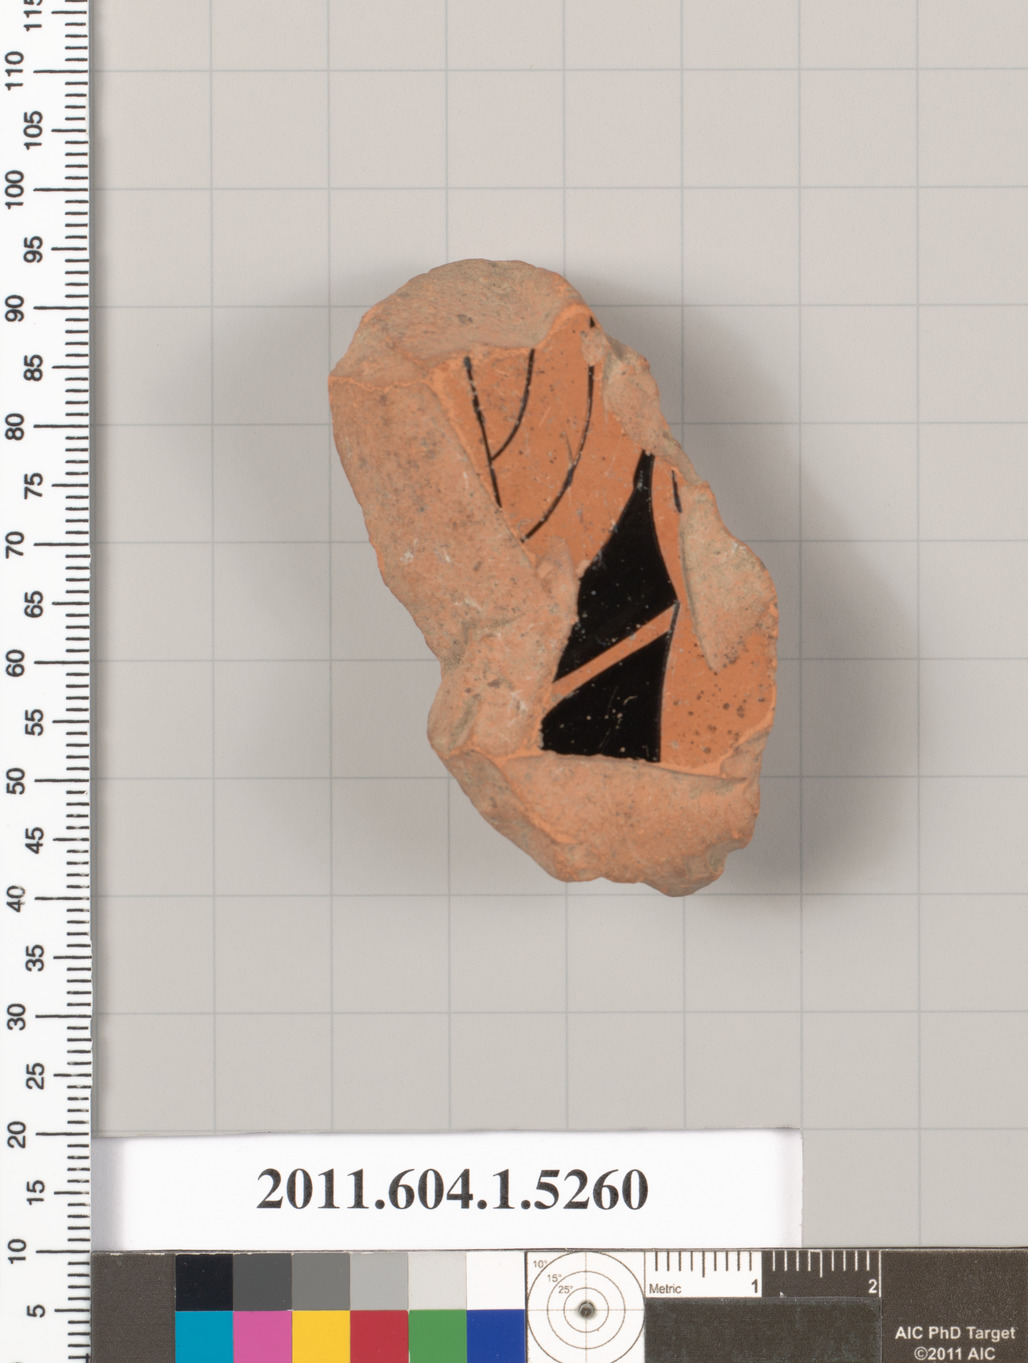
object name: kylix fragment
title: Terracotta fragment of a kylix (drinking cup)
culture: greek, attic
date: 500-480 BCE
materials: terracotta